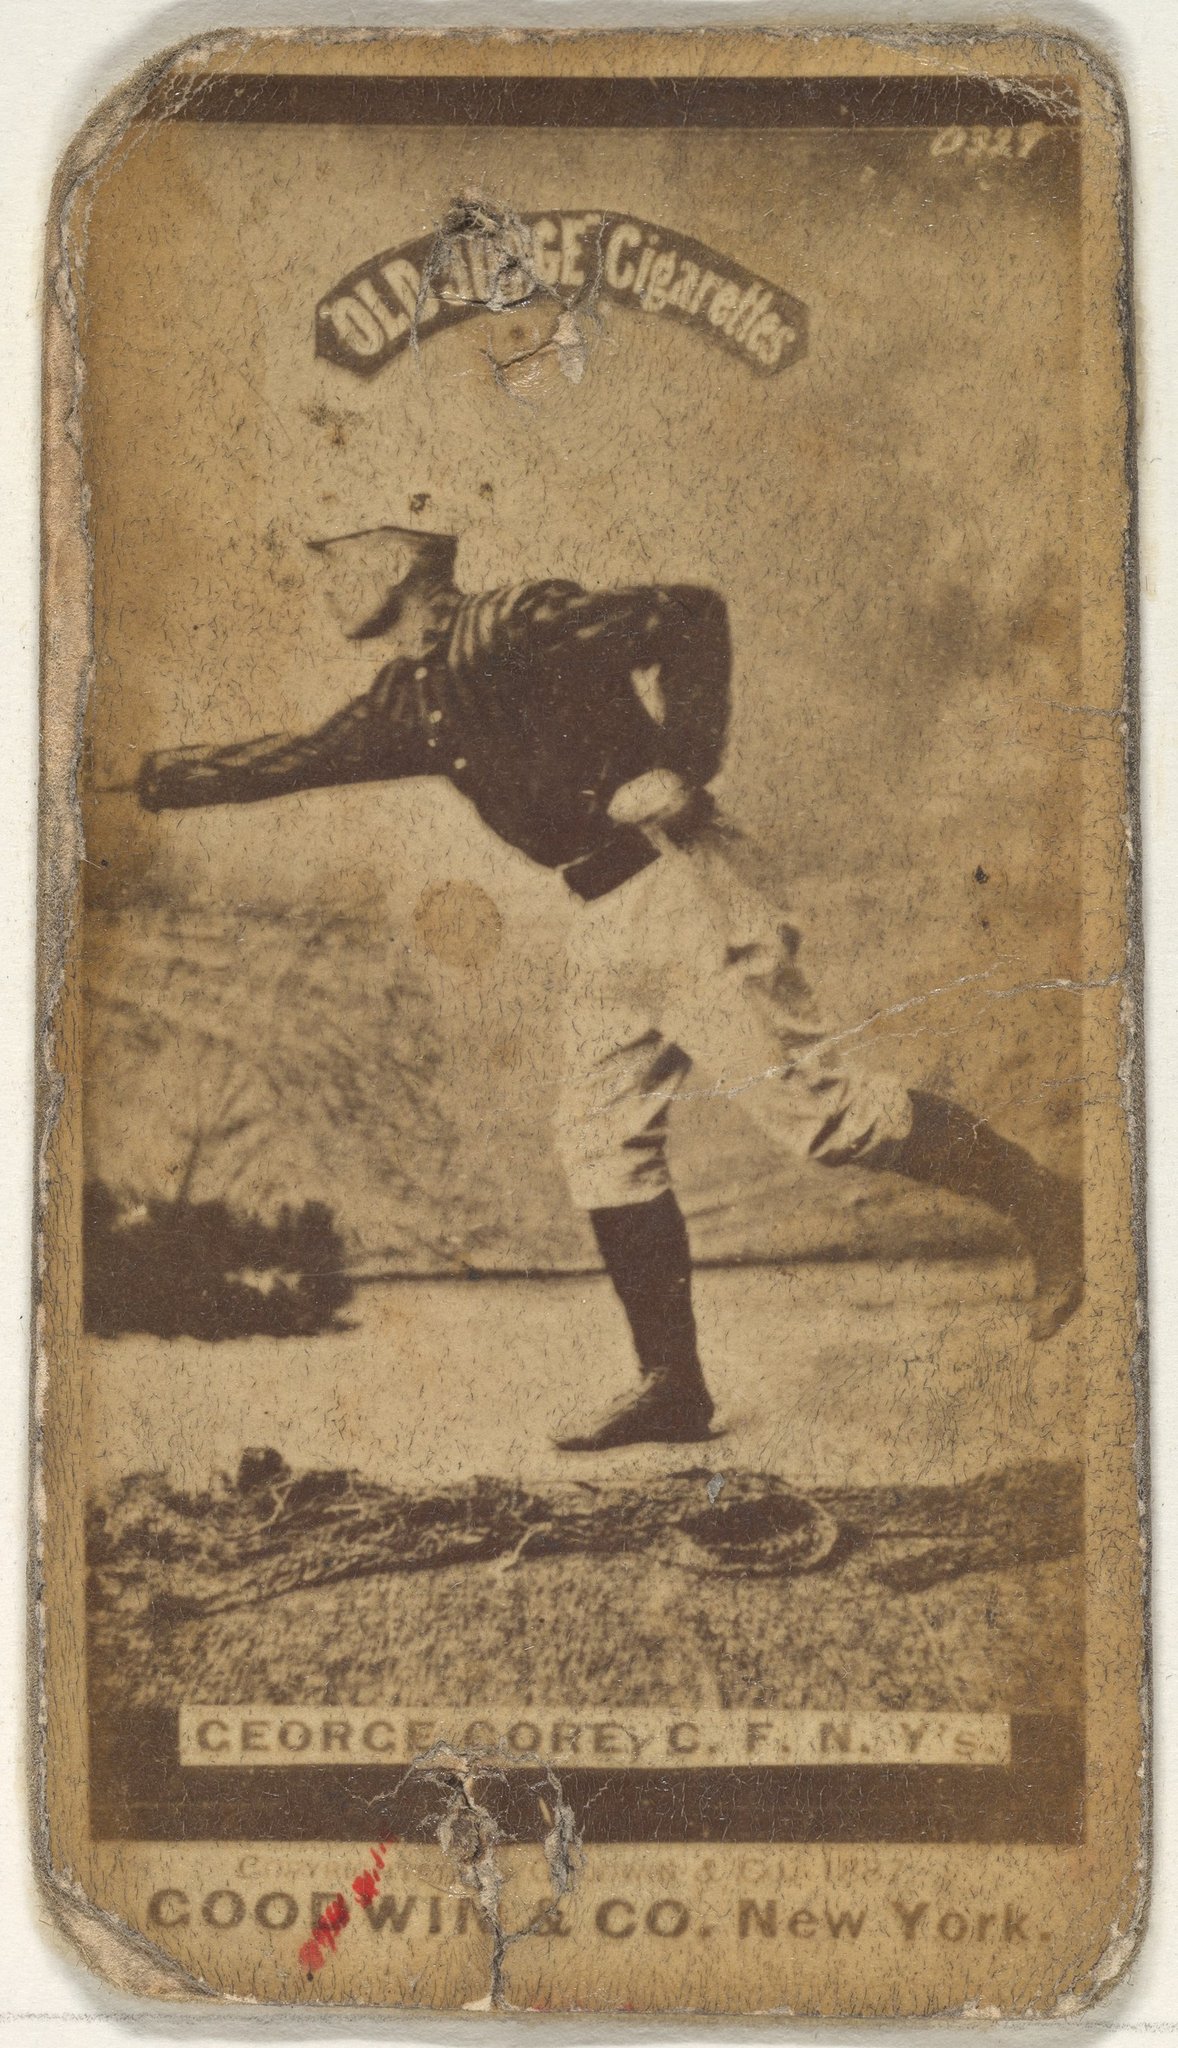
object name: baseball card, photograph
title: George F. "Piano Legs" Gore, Center Field, New York, from the Old Judge series (N172) for Old Judge Cigarettes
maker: goodwin & company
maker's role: publisher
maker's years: 1850-1950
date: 1887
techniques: albumen silver print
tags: men,portraits,baseball,athletes